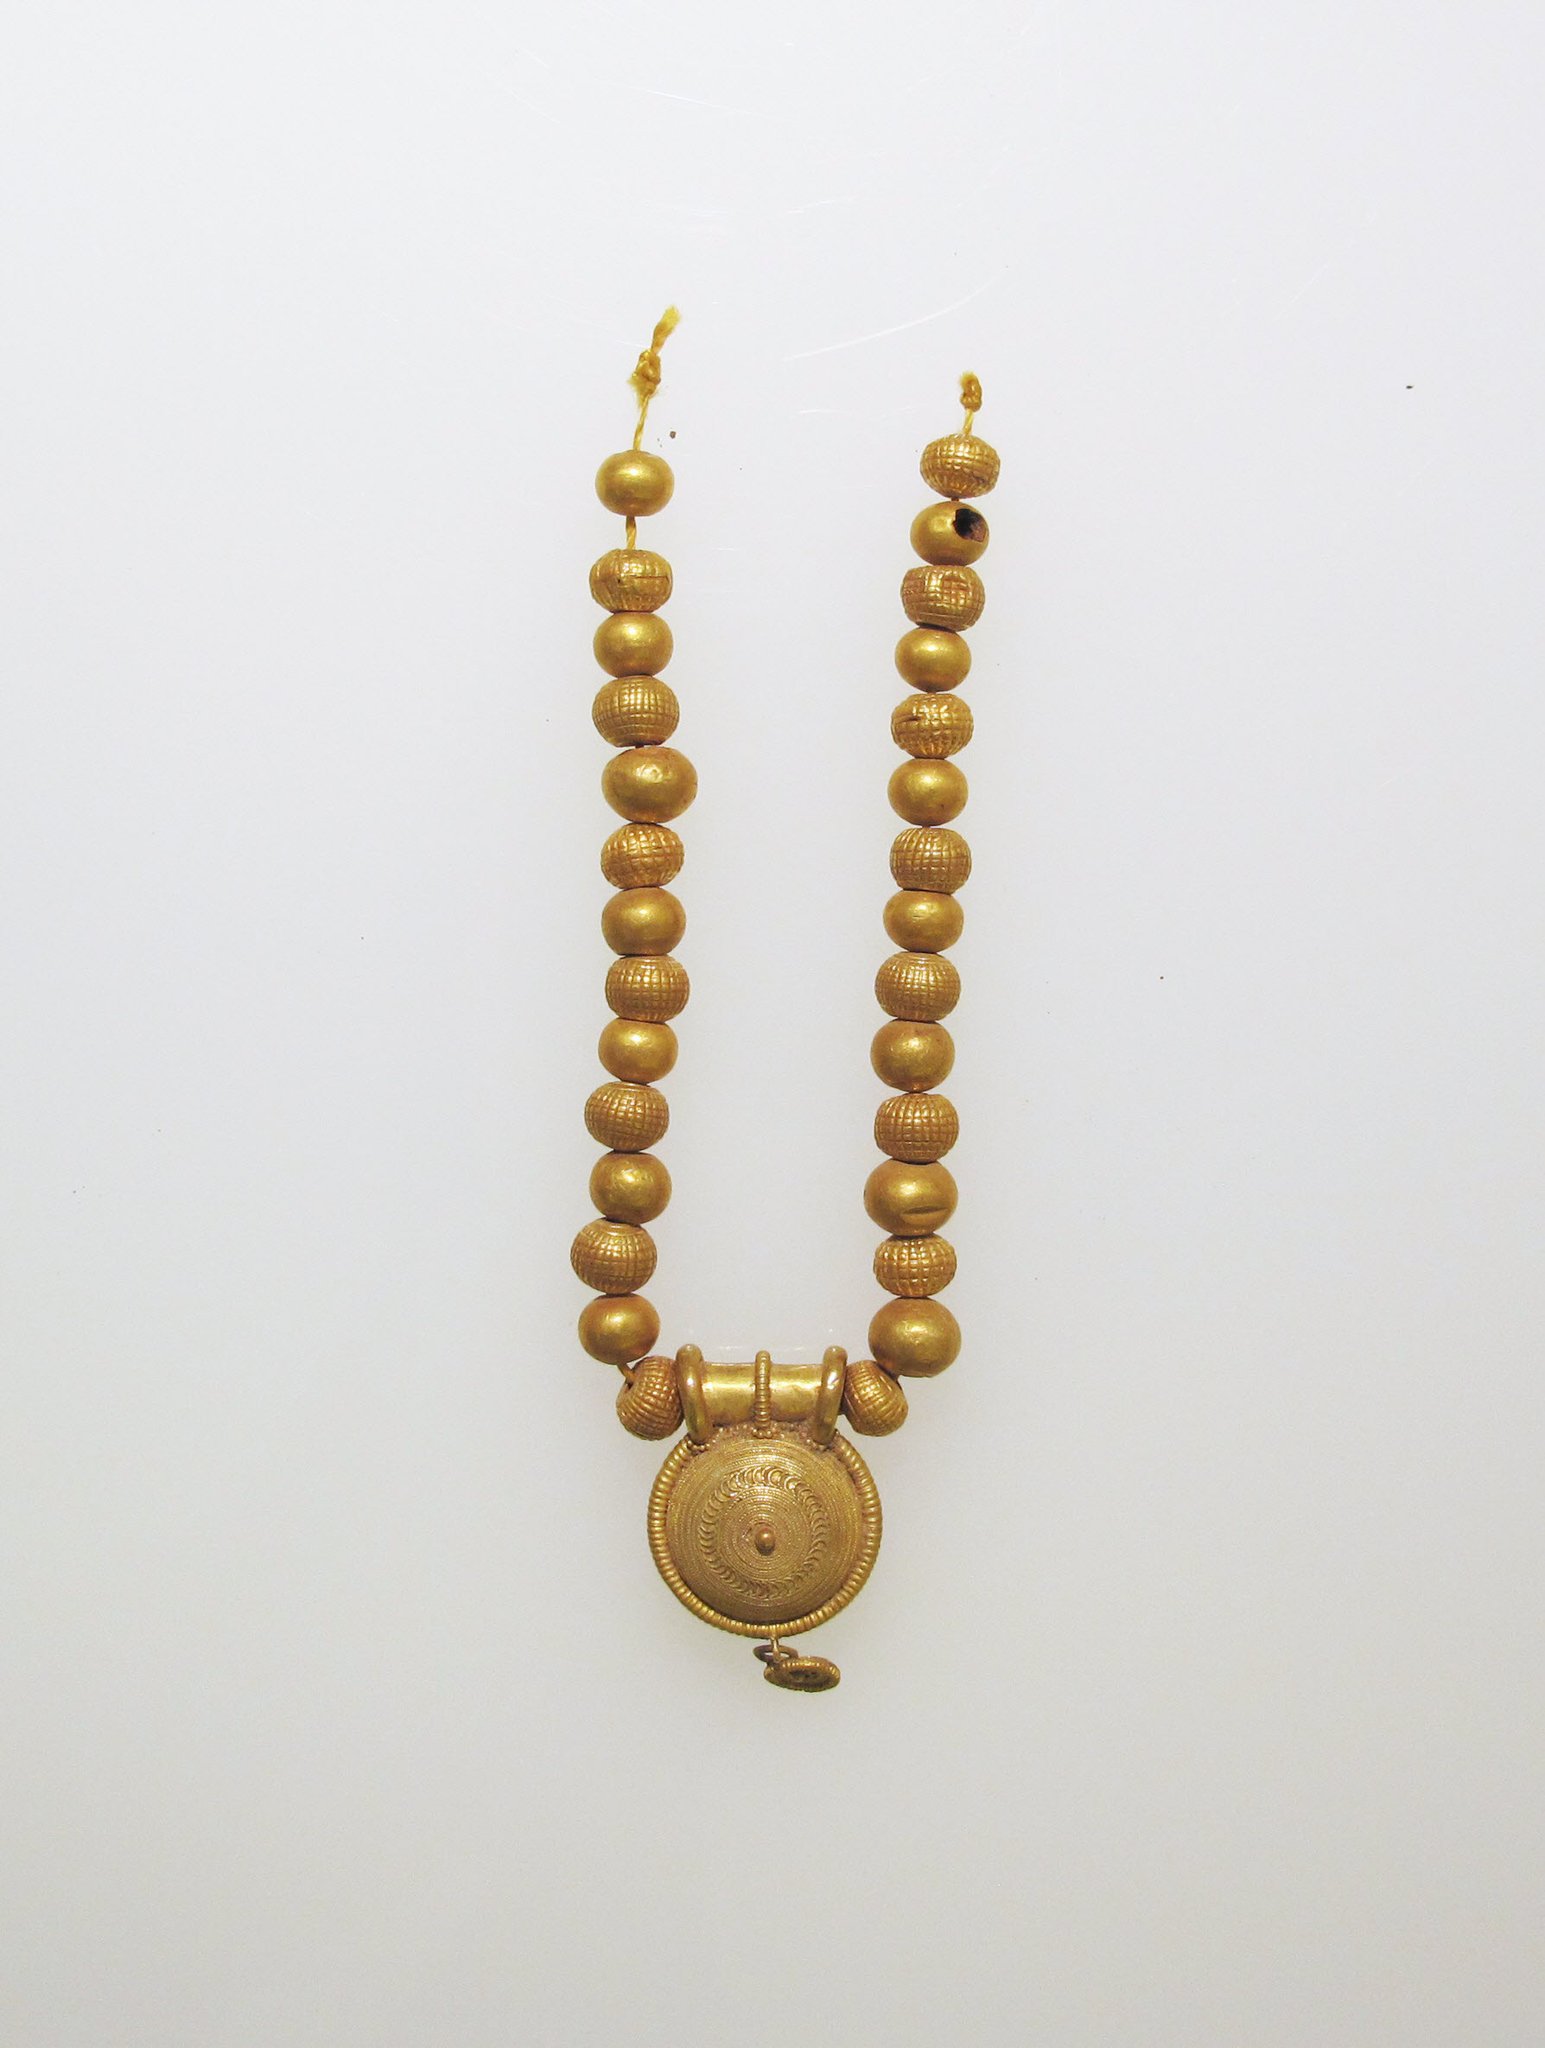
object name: necklace with bulla and gold bead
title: Necklace with bulla and gold beads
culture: etruscan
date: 700-401 BCE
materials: gold